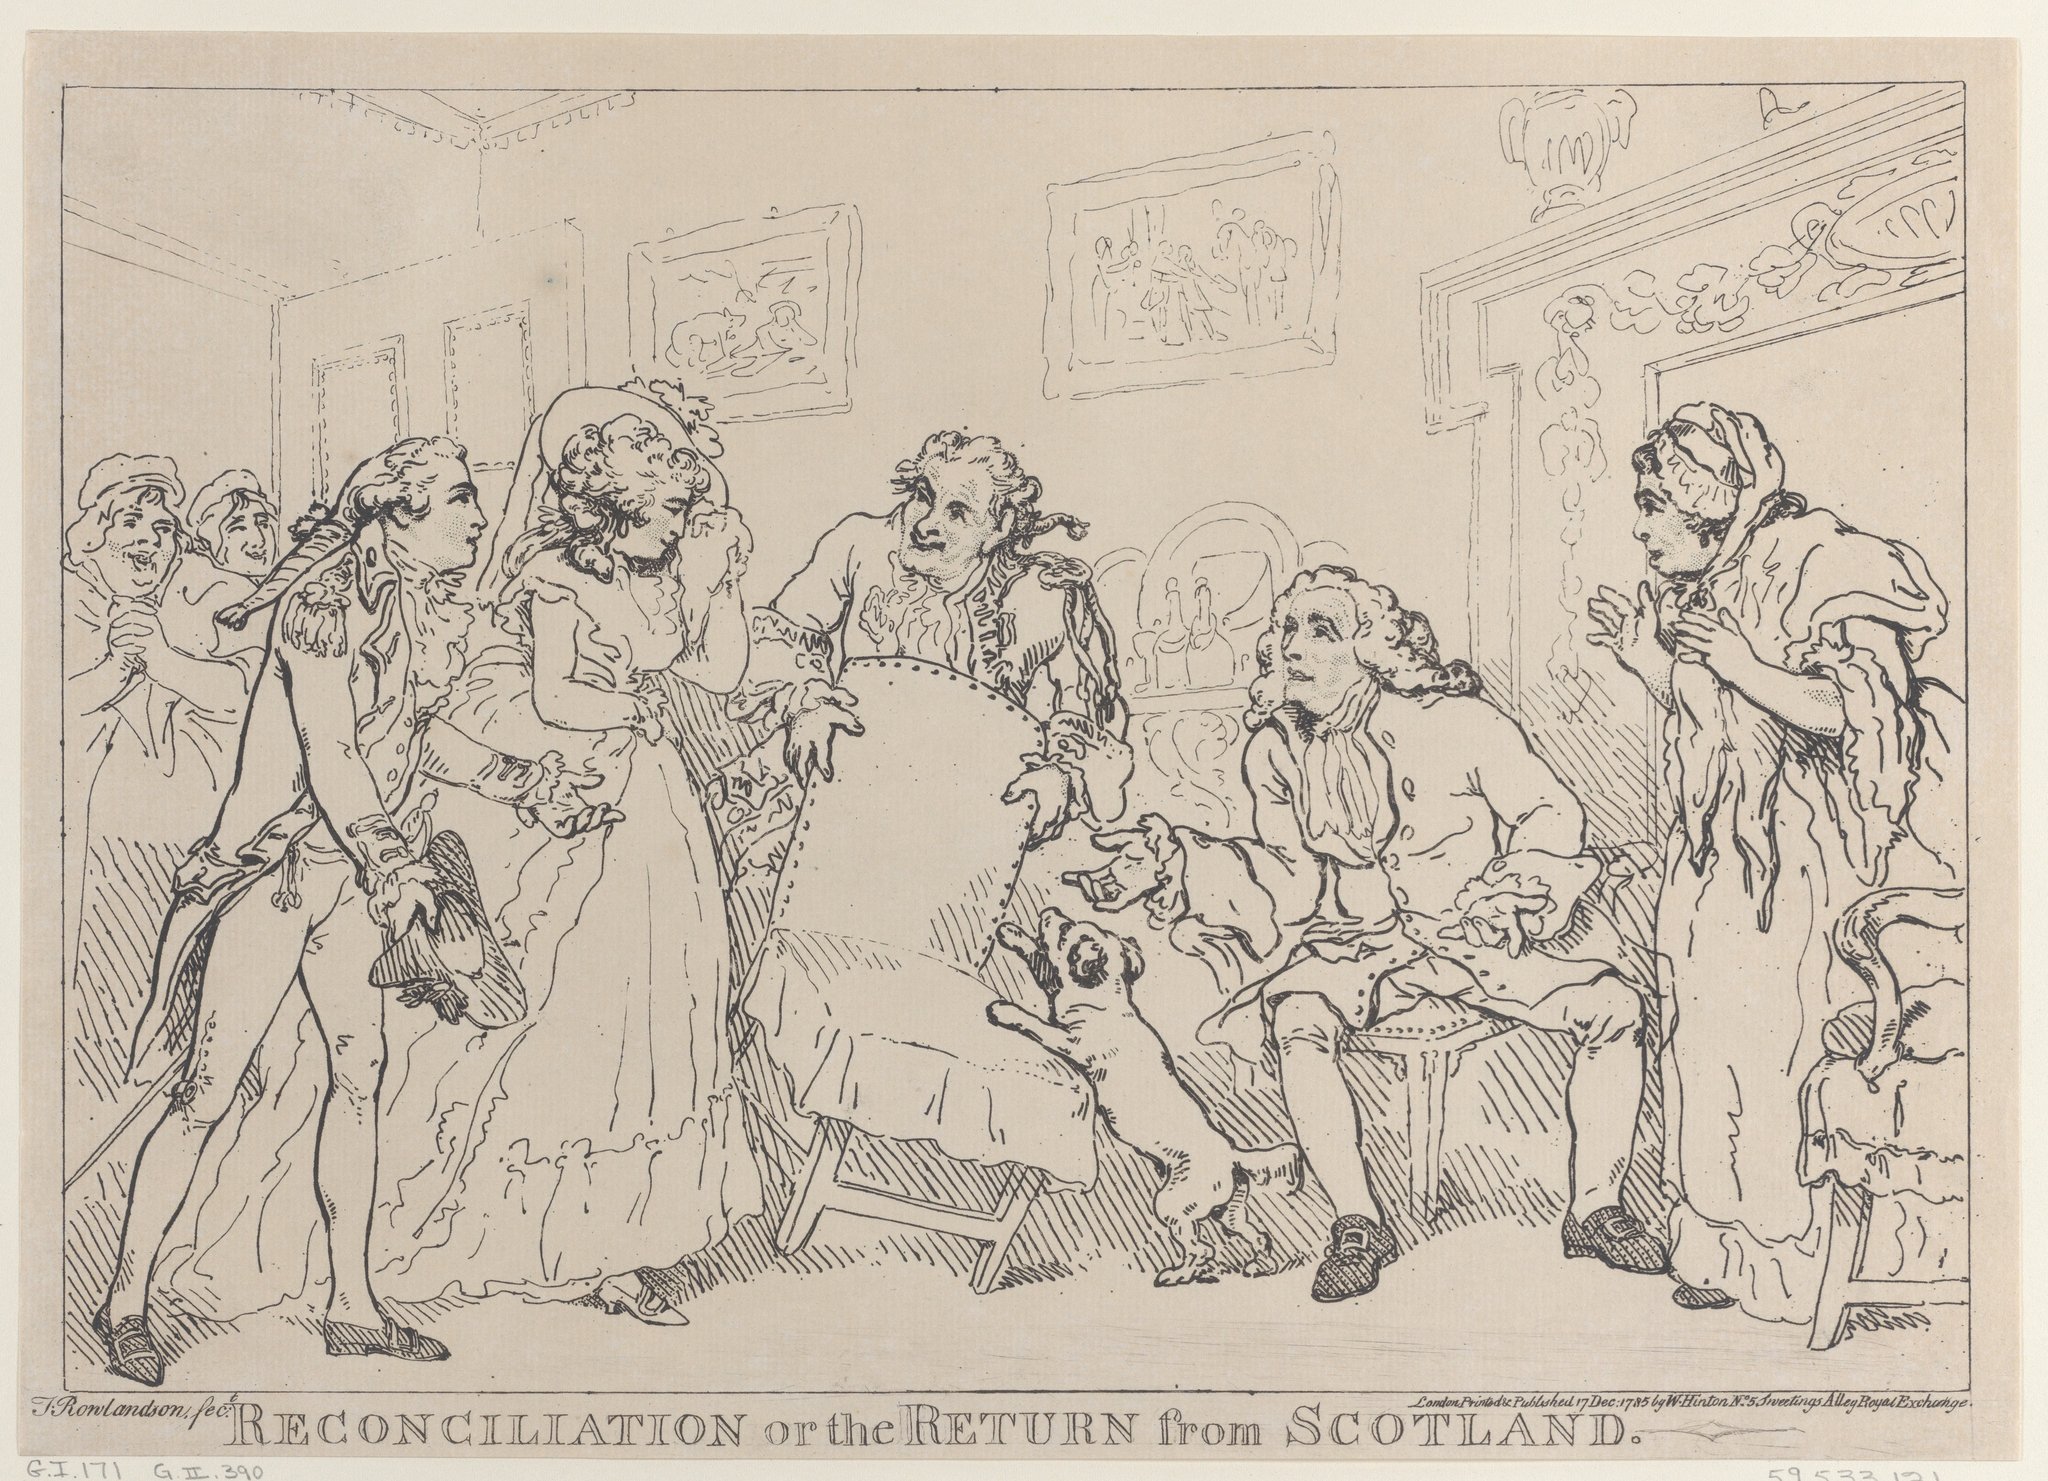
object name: print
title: Reconciliation, or the Return from Scotland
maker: thomas rowlandson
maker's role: artist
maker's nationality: british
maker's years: 1757-1827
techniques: etching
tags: satire,men,women,dogs